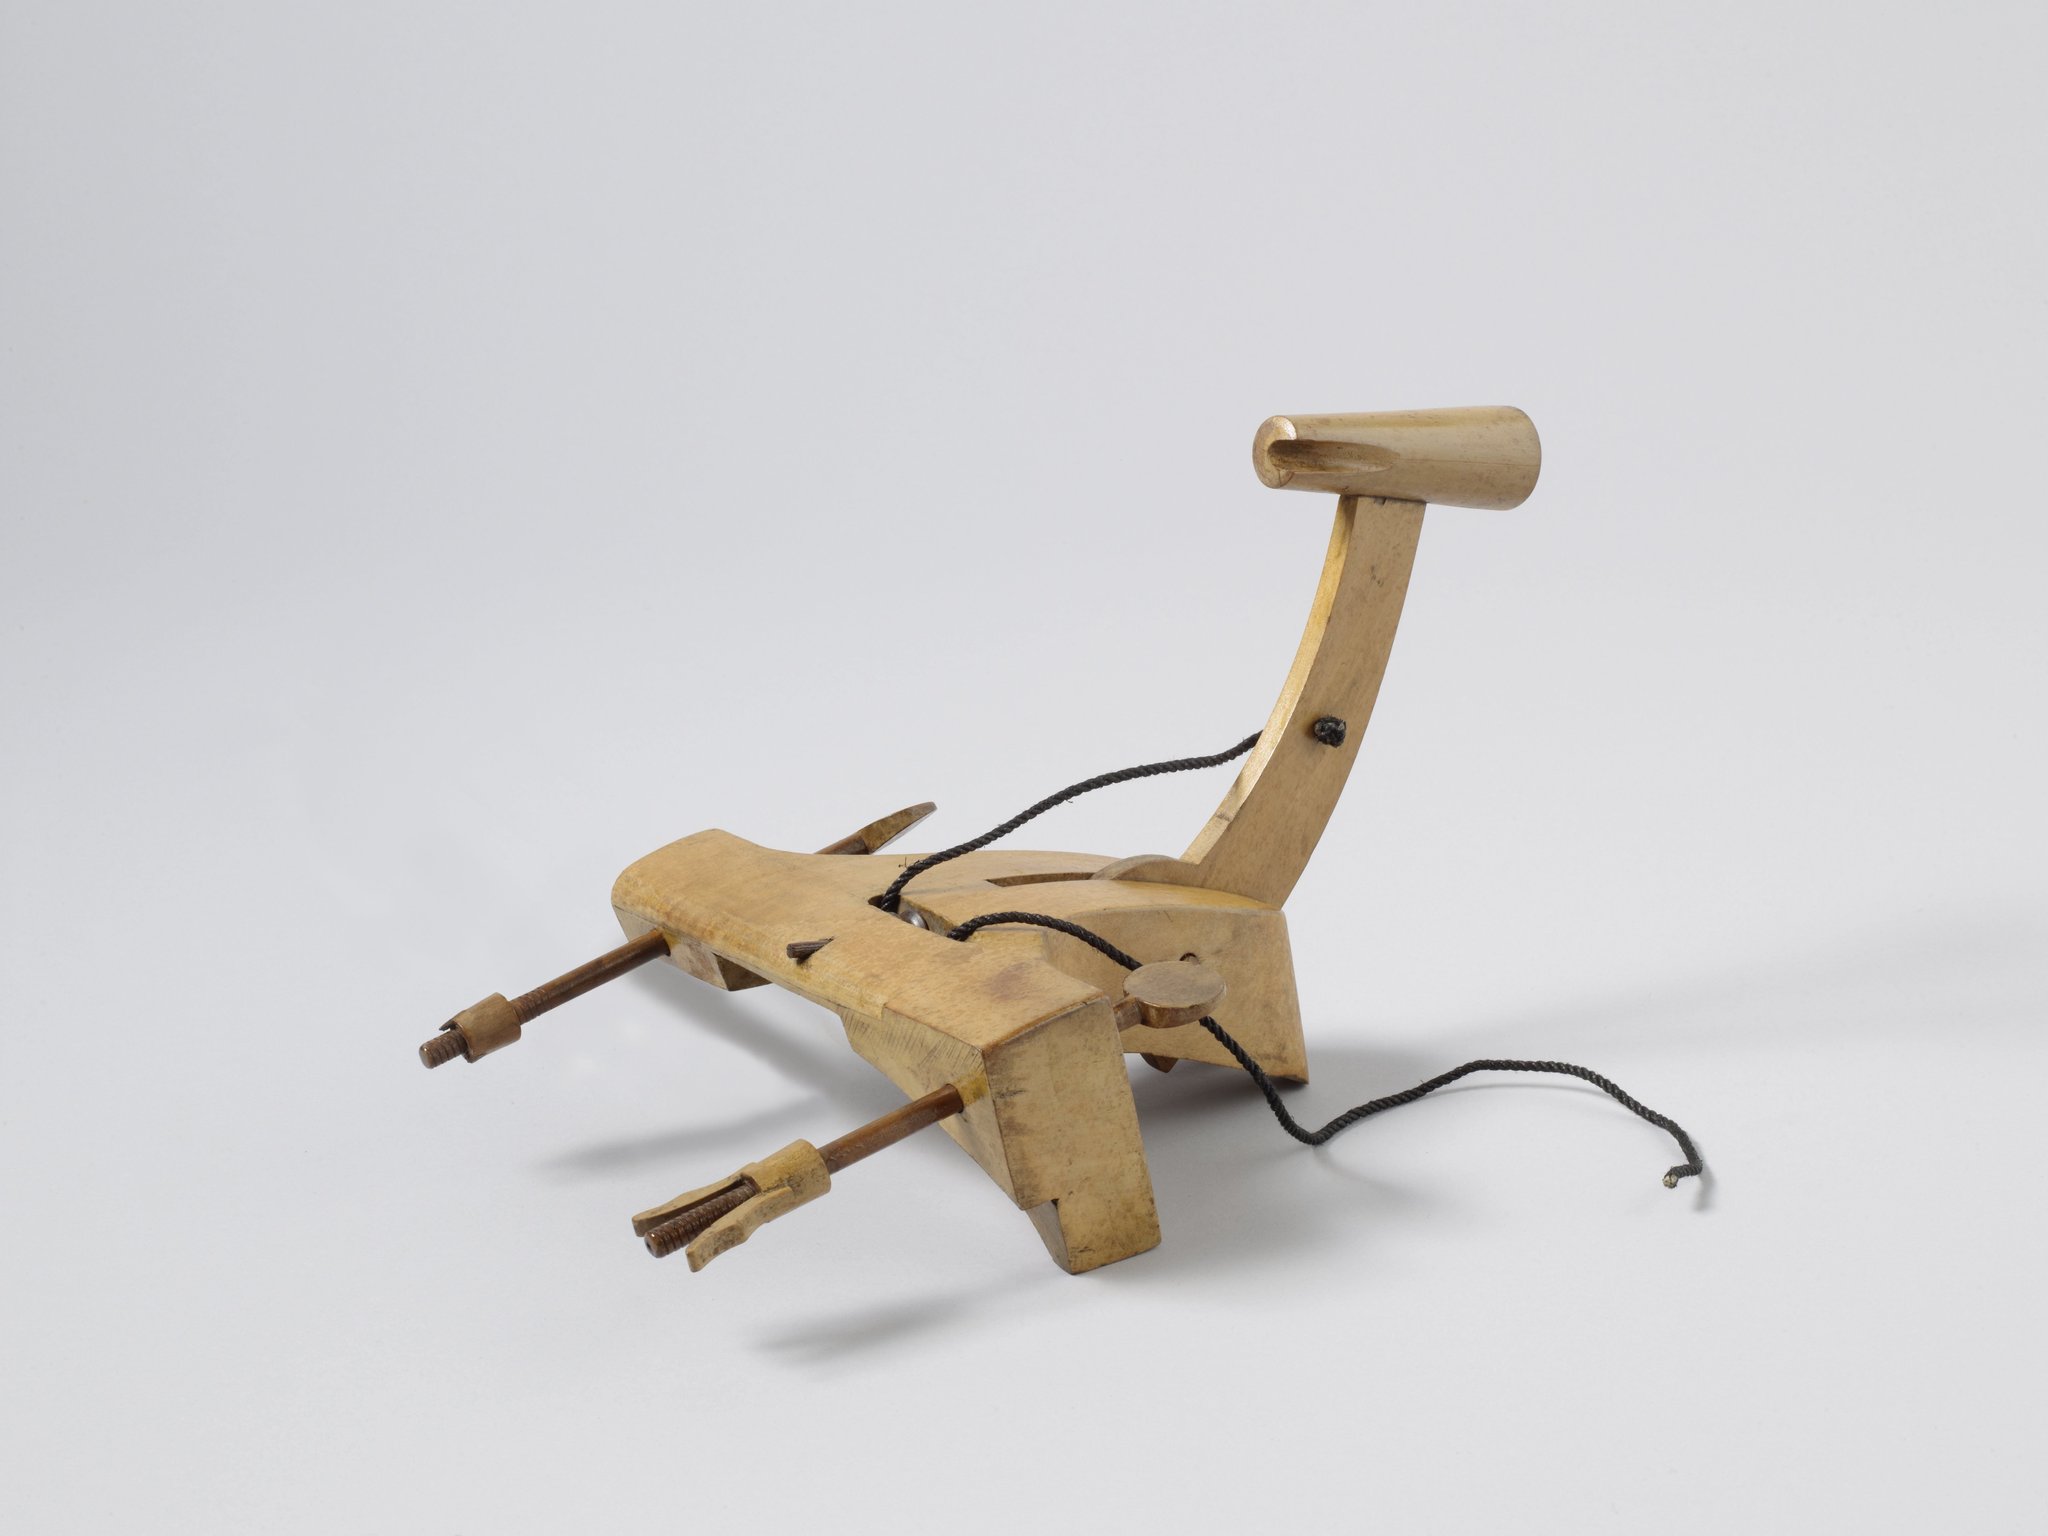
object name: demonstration model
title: Model of a Gunlock (Percussion)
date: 1835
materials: fiber, wood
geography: flushing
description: Houten model van een percussieslot, ontwerpen voor NG-MC-707, NG-MC-708 en NG-MC-710. In principe zijn zij identiek, het verschil is gelegen bij de vorm van de slotplaat, die verschilt naargelang het geschut waarvoor het slot bedoeld is. De slotplaat moet aan de rechterzijde tegen de slotverhevenheid gemonteerd worden met twee bouten er dwars doorheen, en twee schroeven in het kulas. De hamer draait in een rechte hoek ten opzichte van de loop. De kop van de hamer heeft een gleuf voor de vlam uit het zundgat als afgevuurd wordt. In de schacht is een gat voor het aftrektouw aangebracht, in de slotplaat een schijf waardoor het touw naar achteren wordt geleid. Schaal 1:1. [gecombineerde beschrijving MC-711-1 t/m 3 (2 compleet met vleugelmoer)]